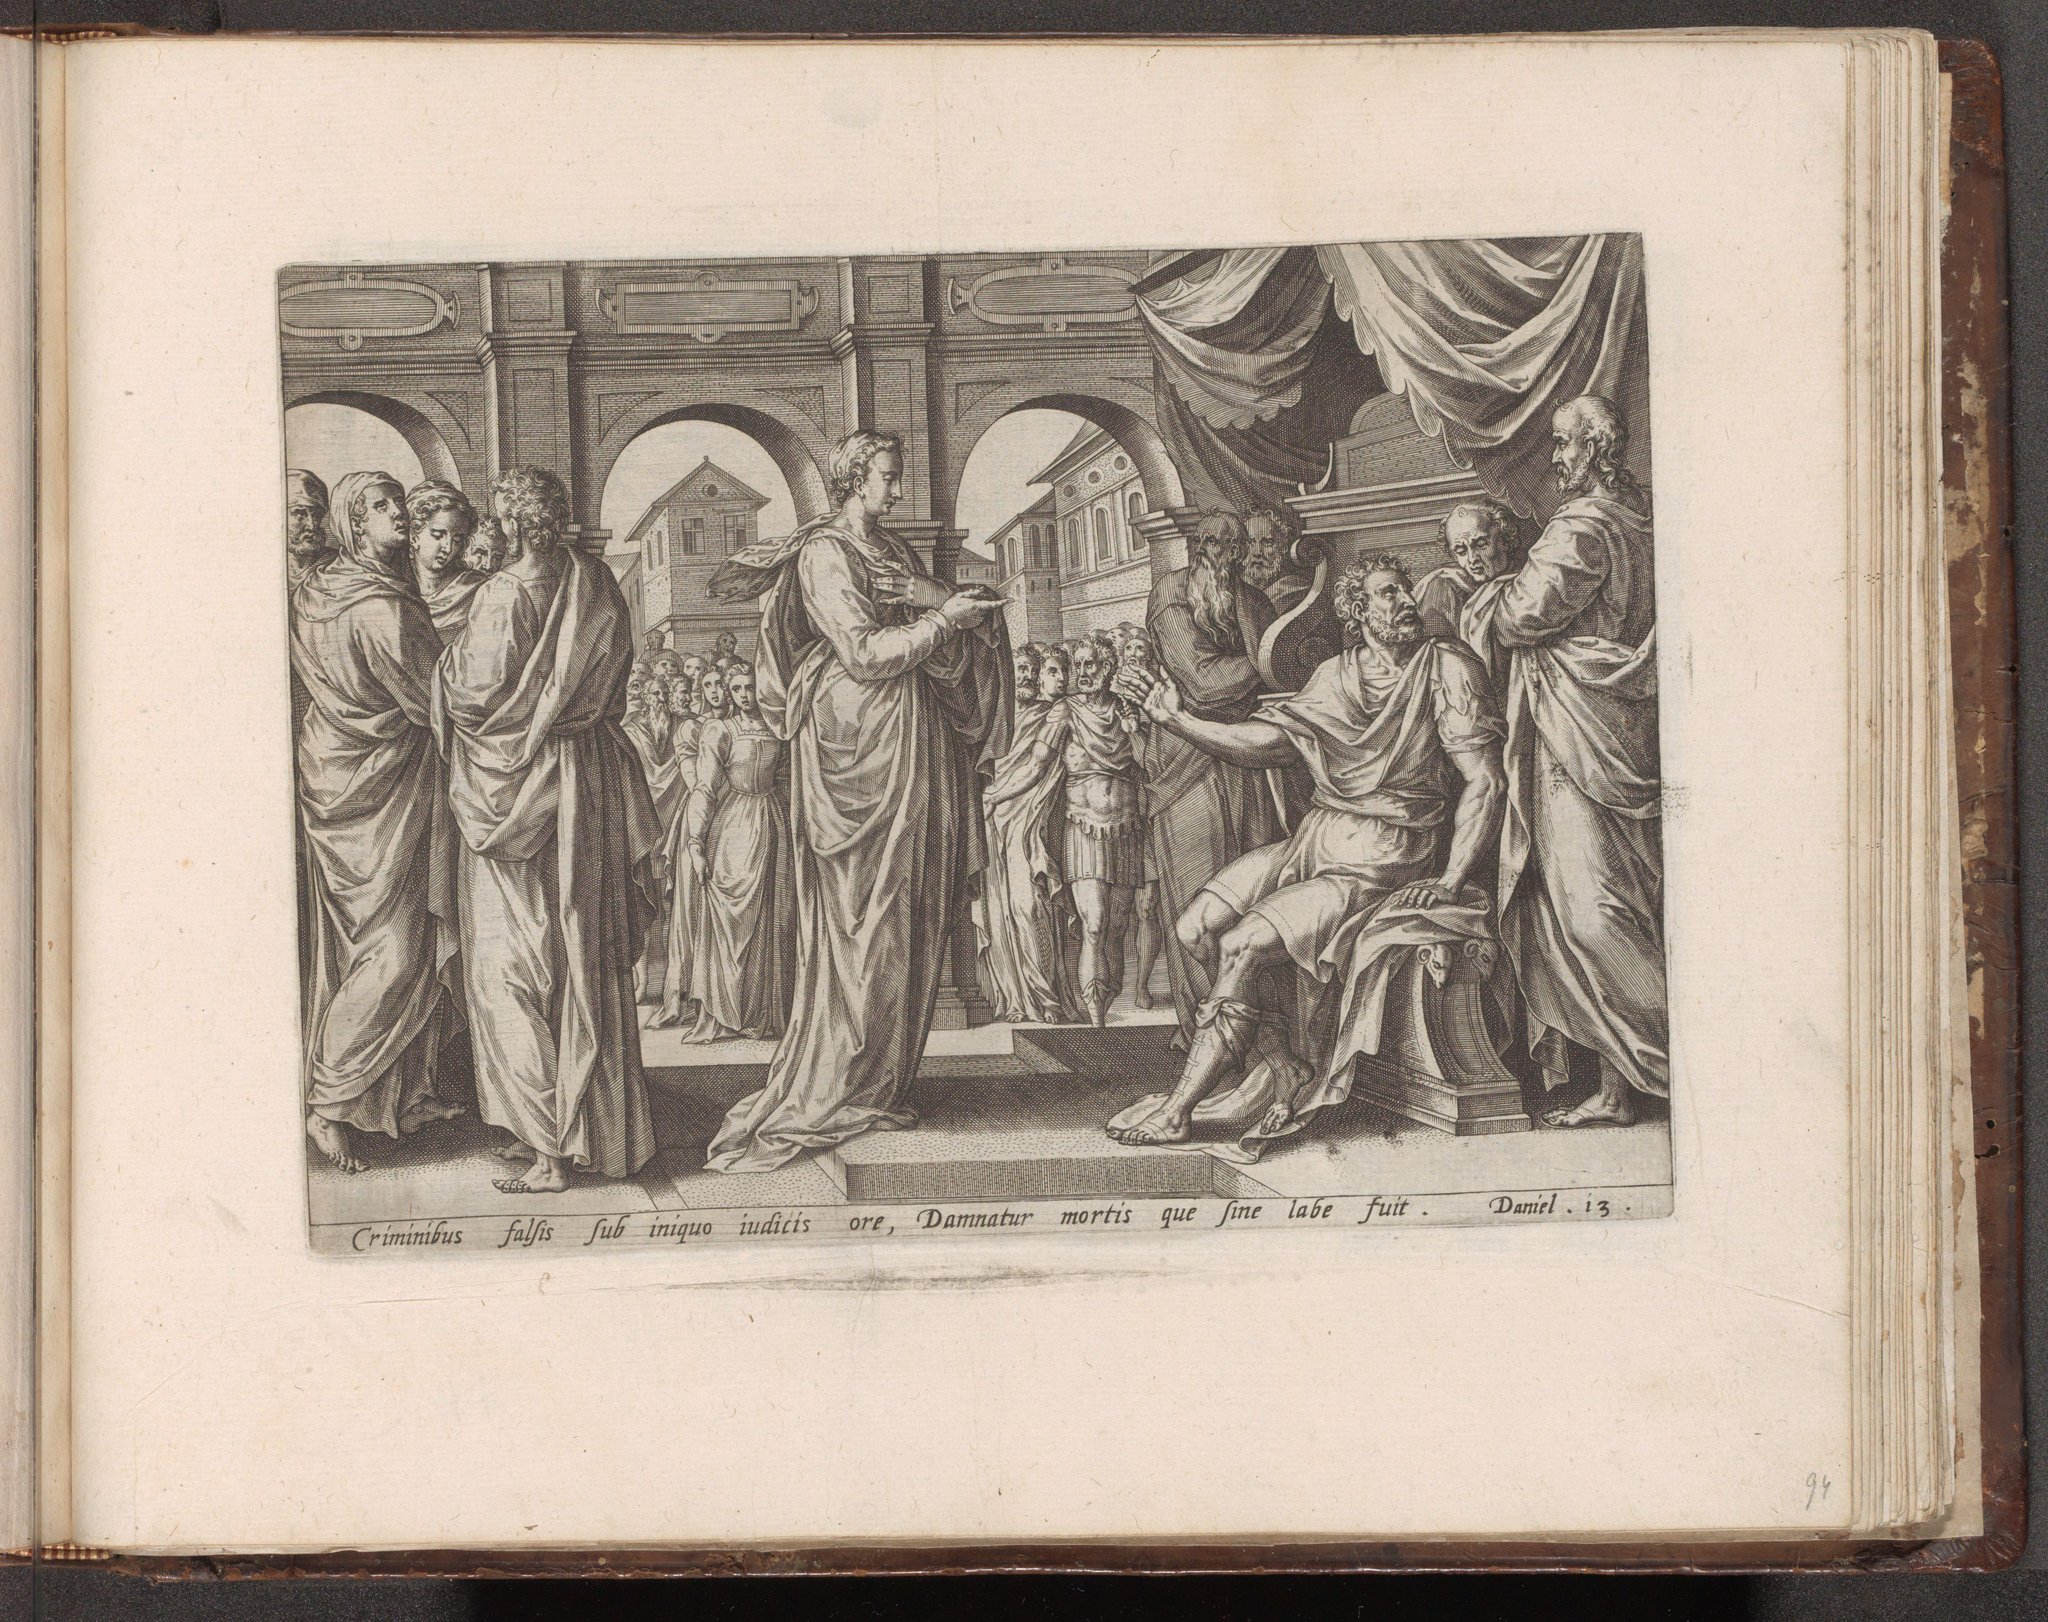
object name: album leaf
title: Susanna beschuldigd door de ouderlingen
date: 1579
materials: paper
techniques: engraving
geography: antwerp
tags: the elders accusing susanna before the people, laying their hands on her head or unveiling her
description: Susanne wordt voor de ouderlingen geleid, die haar beschuldigen van ontrouw. Als rechters veroordelen ze haar ook. Onder de voorstelling een verwijzing in het Latijn naar de Bijbeltekst in Dan. 13:41. Prent maakt deel uit van een album.